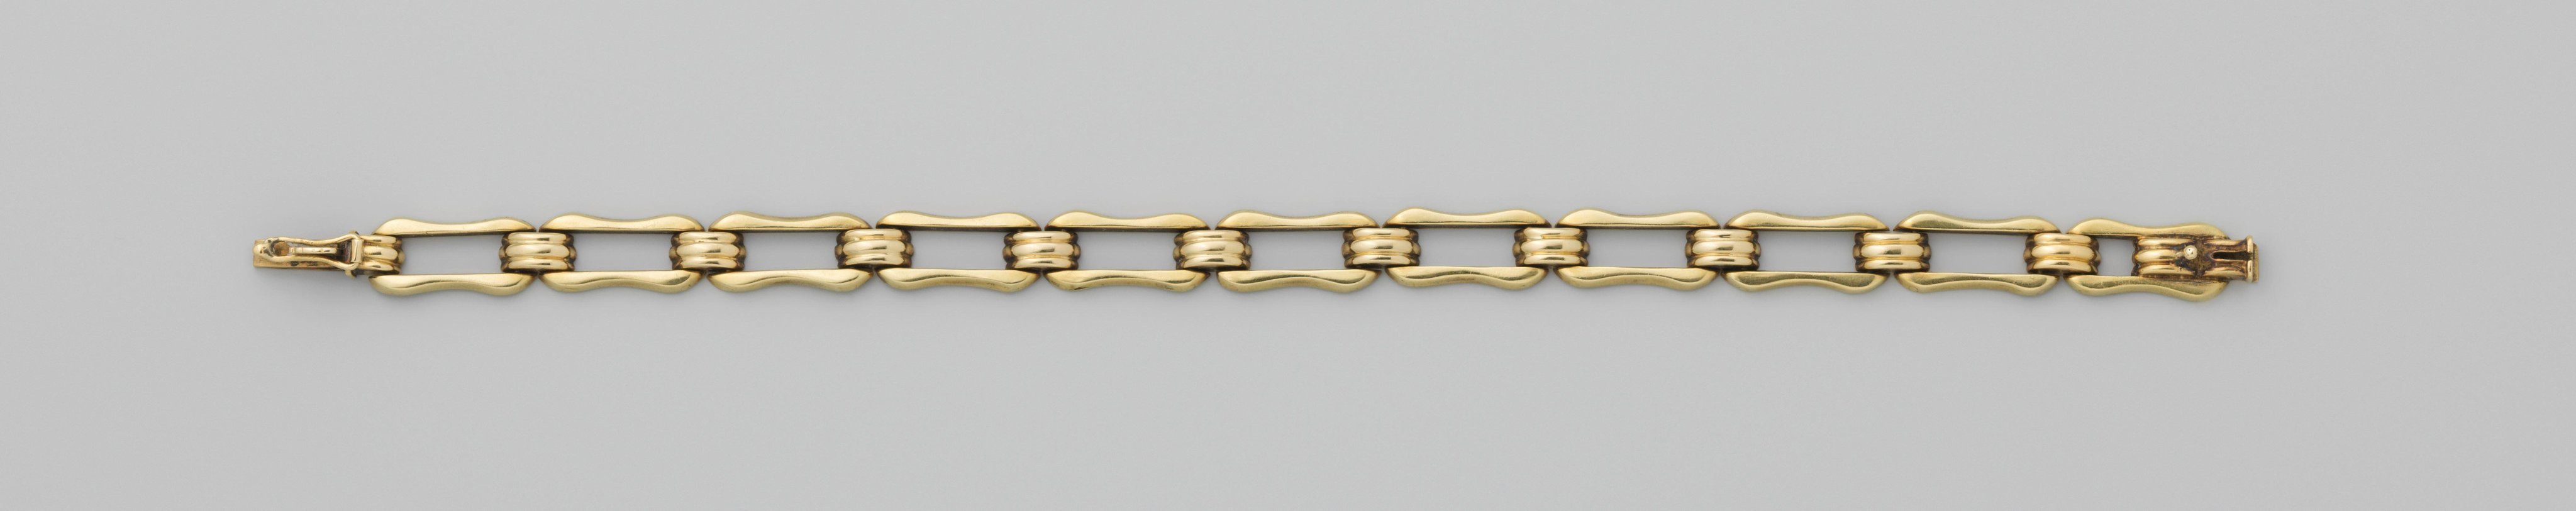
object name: bracelet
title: Armband van goud, smal model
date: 1960-1970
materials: gold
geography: voorschoten